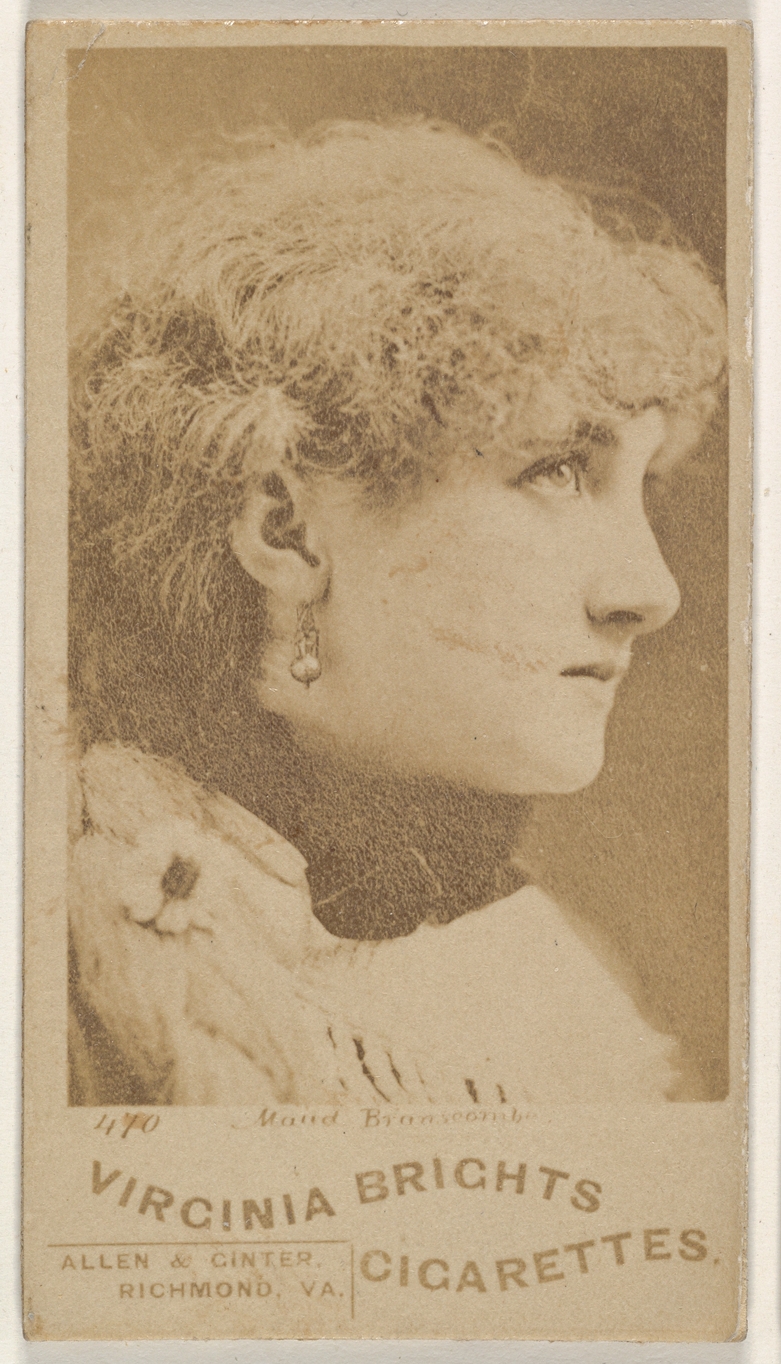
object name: photograph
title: Card 470, Maud Branscombe, from the Actors and Actresses series (N45, Type 1) for Virginia Brights Cigarettes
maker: allen & ginter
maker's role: publisher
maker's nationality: american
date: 1888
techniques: albumen silver print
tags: portraits,women,actresses